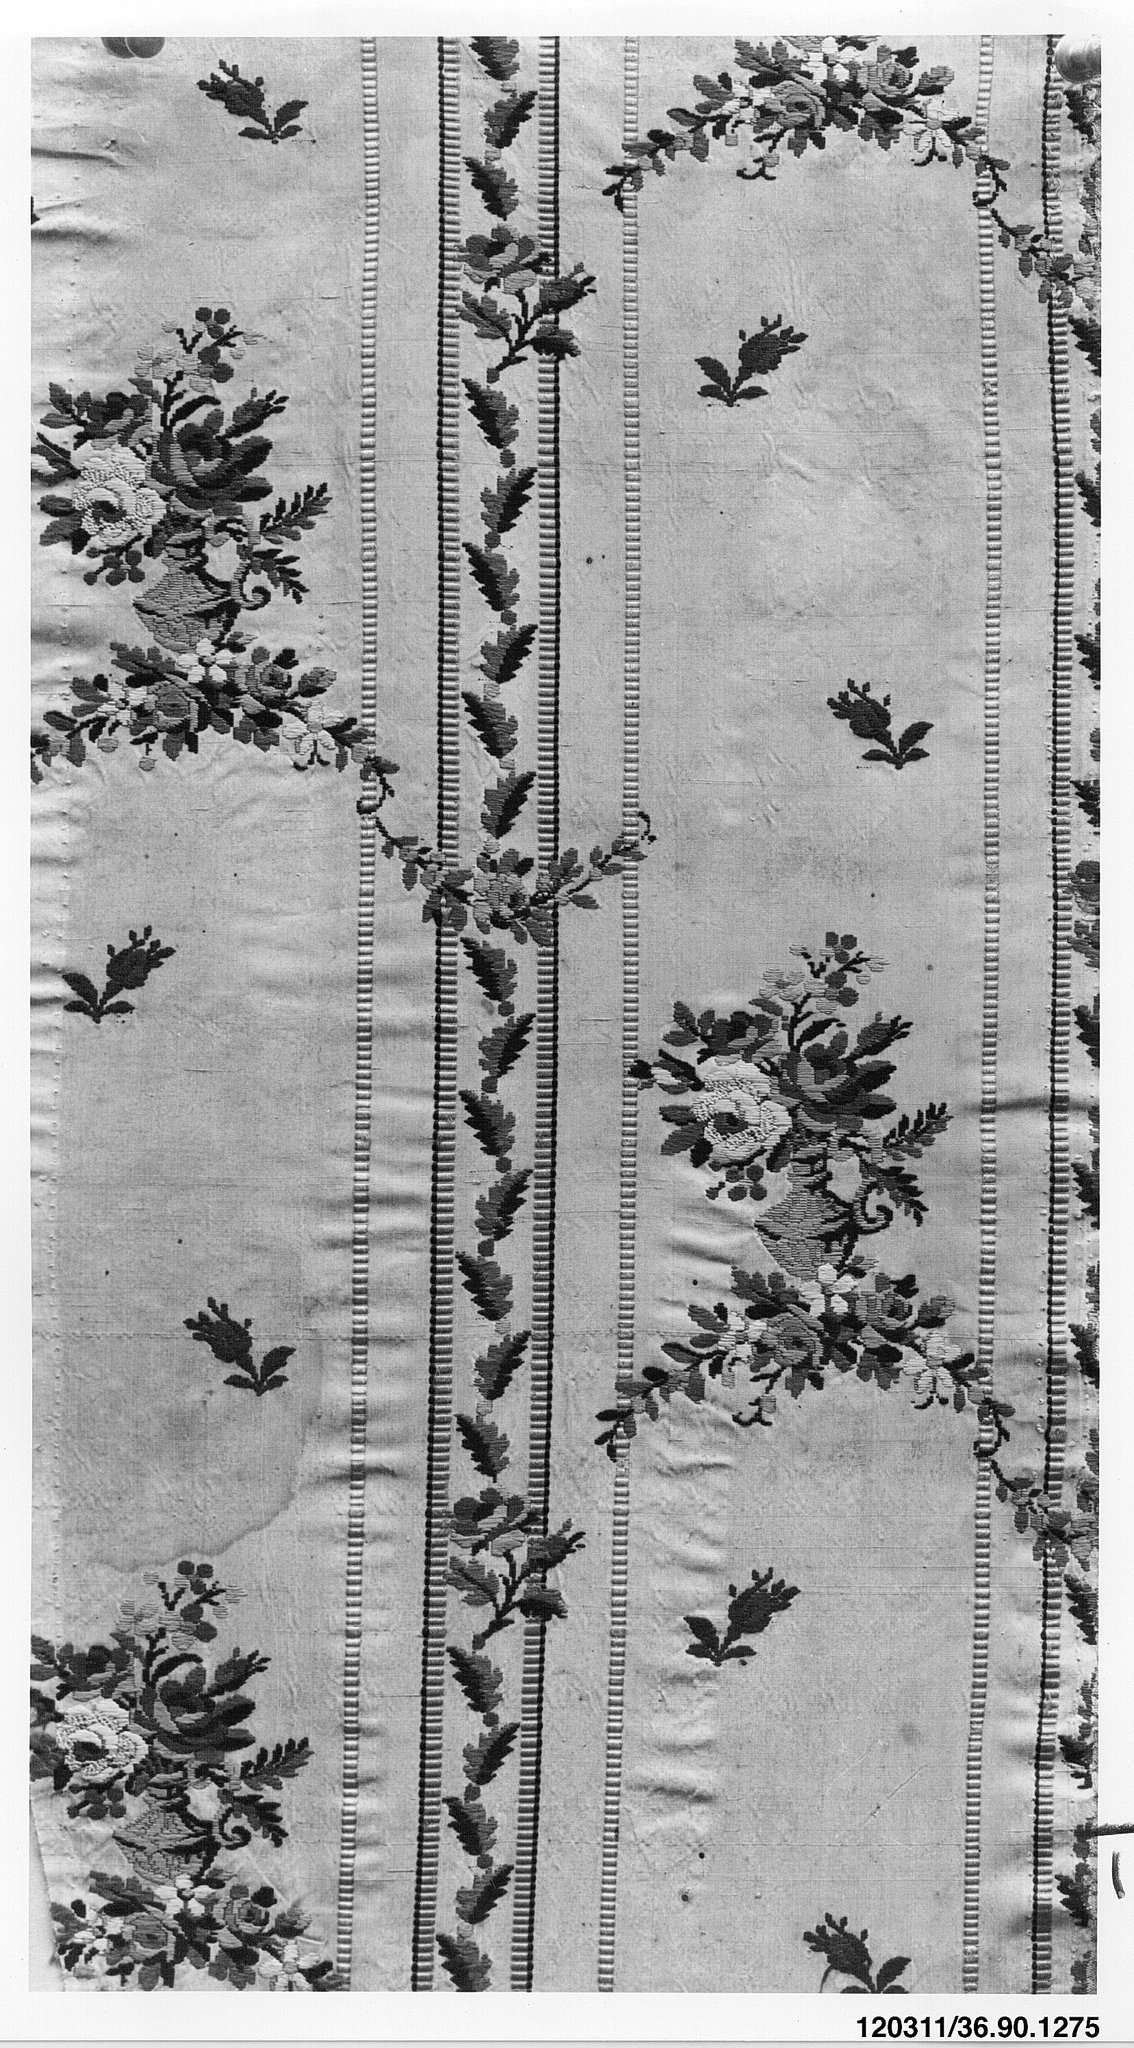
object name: piece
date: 1701-1800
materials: silk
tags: flowers,leaves